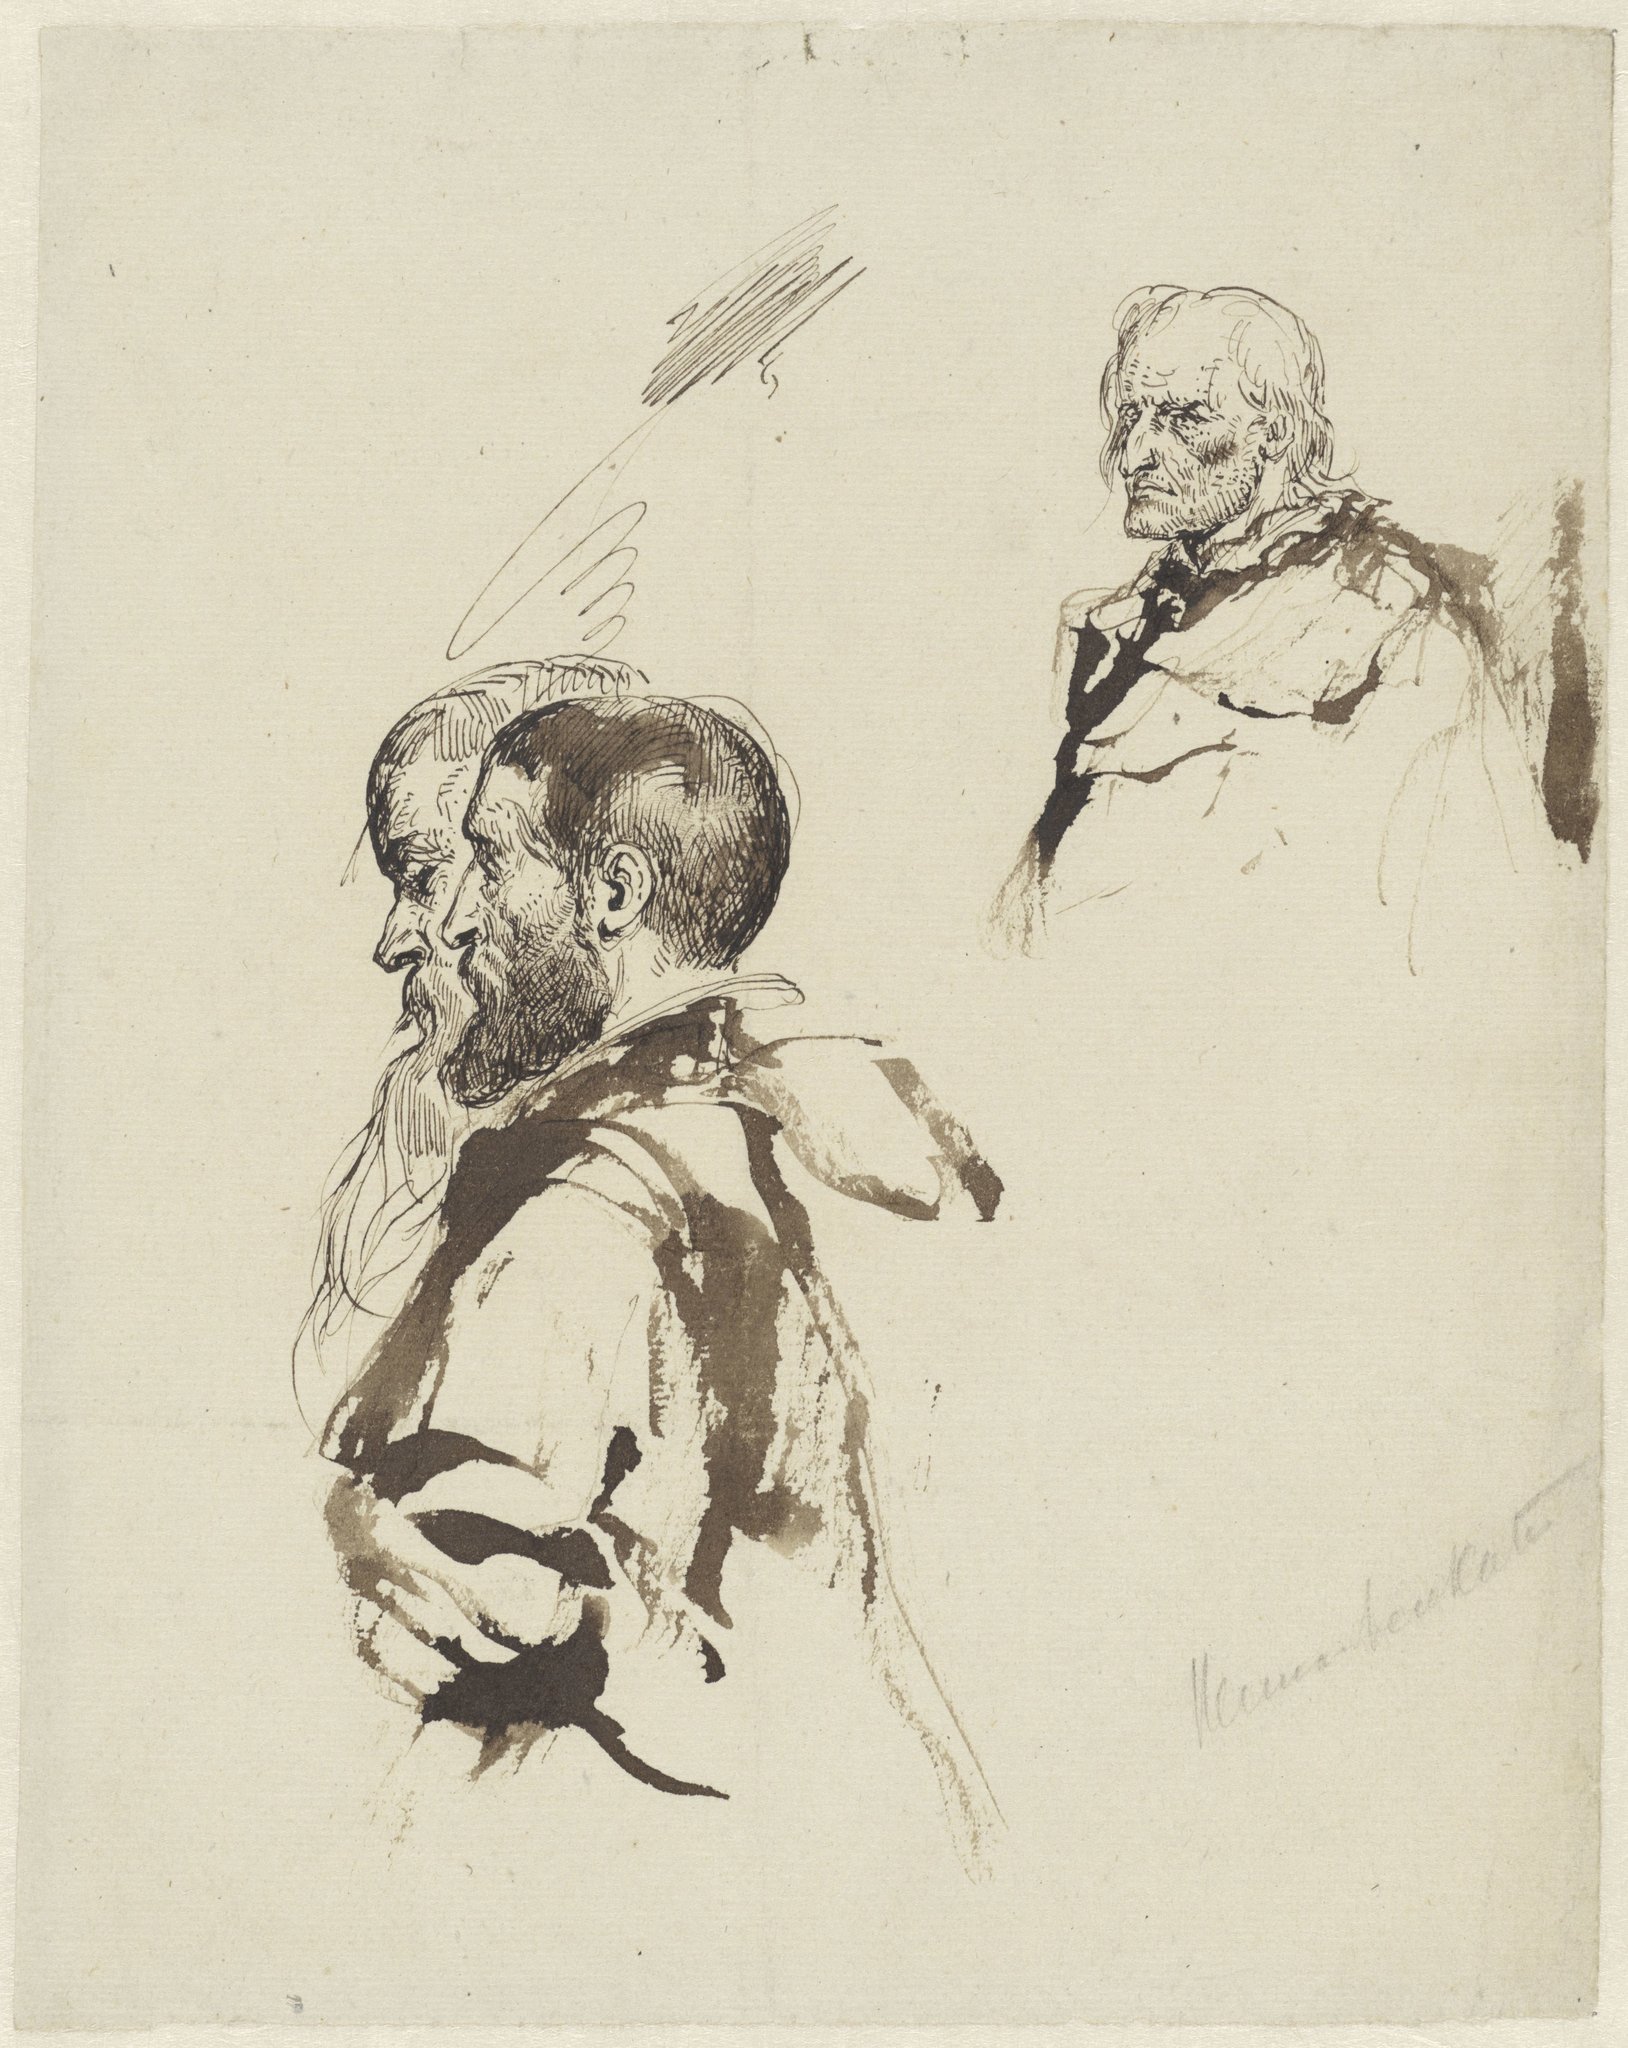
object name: drawing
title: Groep van twee figuren en een oude mannenkop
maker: herman frederik carel ten kate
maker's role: draughtsman, painter, print maker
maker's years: 1822-1891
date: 1832-1891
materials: ink, paper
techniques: brush, pen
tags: male sex; man